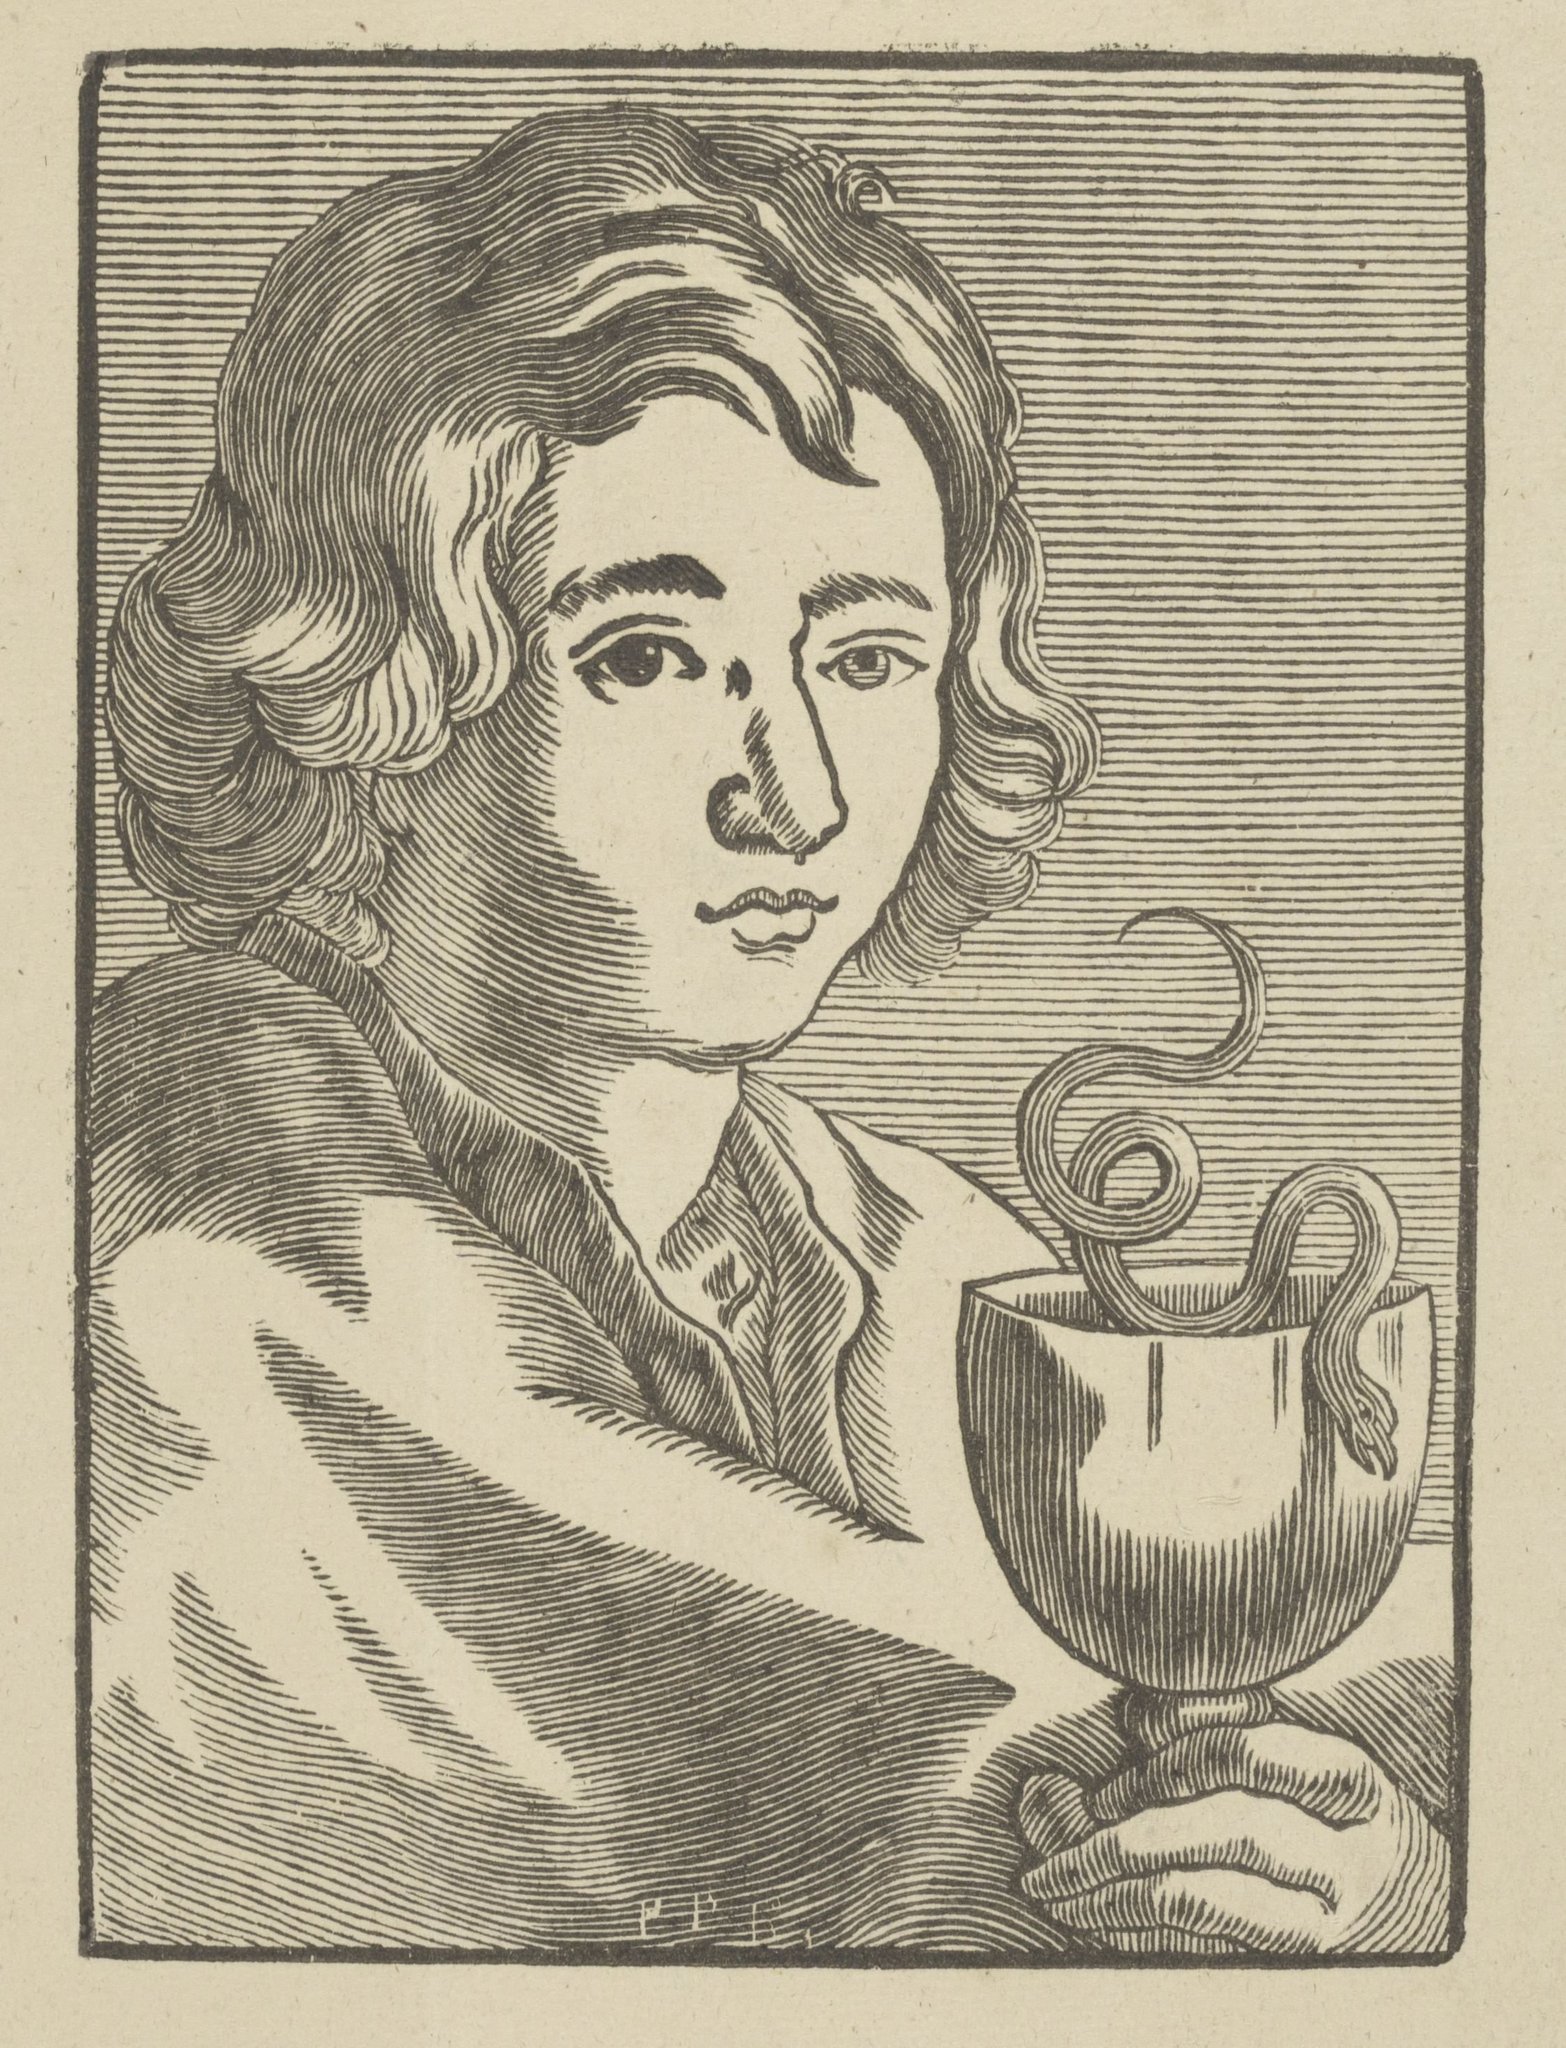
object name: print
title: Johannes de evangelist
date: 1600-1699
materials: paper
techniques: woodcut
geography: netherlands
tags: the apostle john the evangelist; possible attributes: book, cauldron, chalice with snake, eagle, palm, scroll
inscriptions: collector's mark: Lugt 240, collector's mark: Lugt 2228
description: Jongeman met een beker waaruit een adder kronkelt.